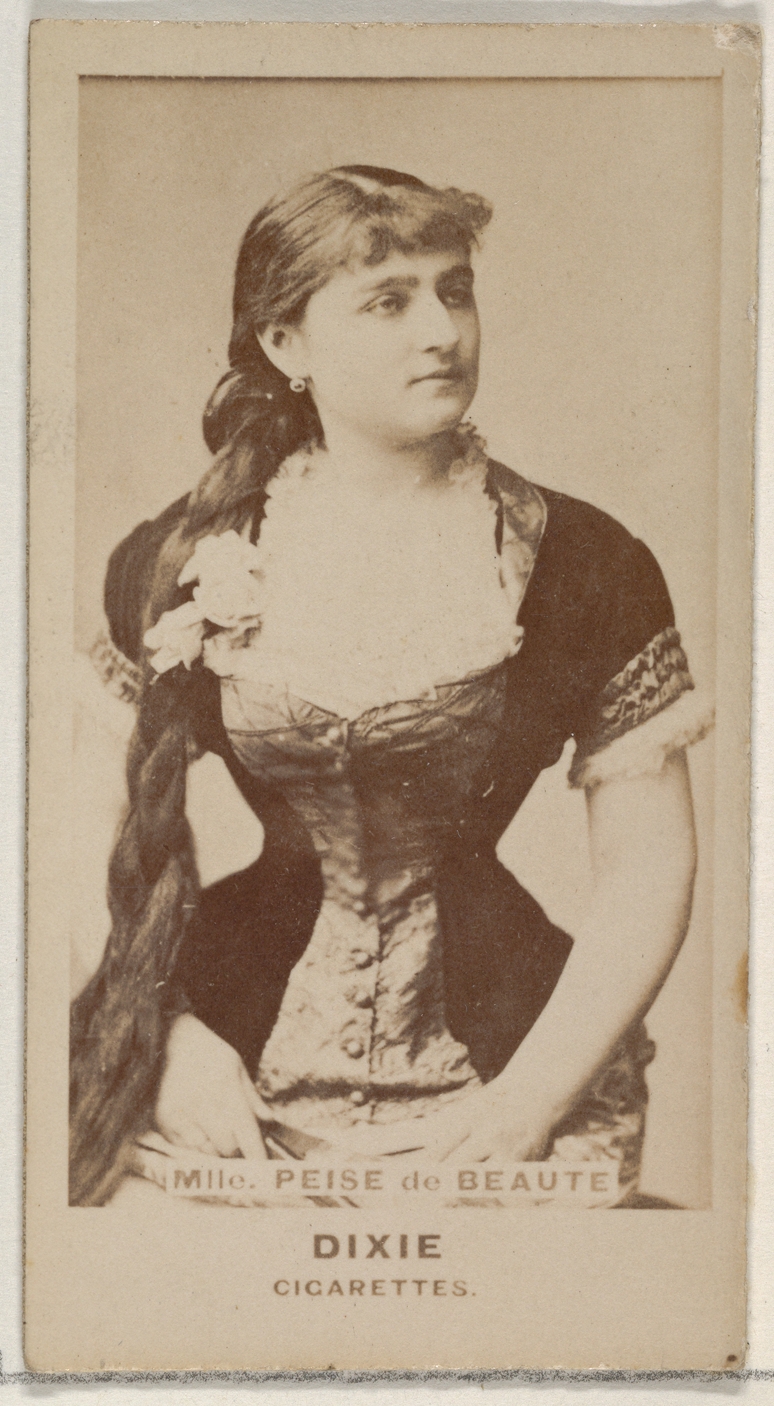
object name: photograph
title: Mlle. Peise de Beaute, from the Actors and Actresses series (N45, Type 7) for Dixie Cigarettes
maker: allen & ginter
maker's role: publisher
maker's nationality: american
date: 1888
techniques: albumen silver print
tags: portraits,women,actresses